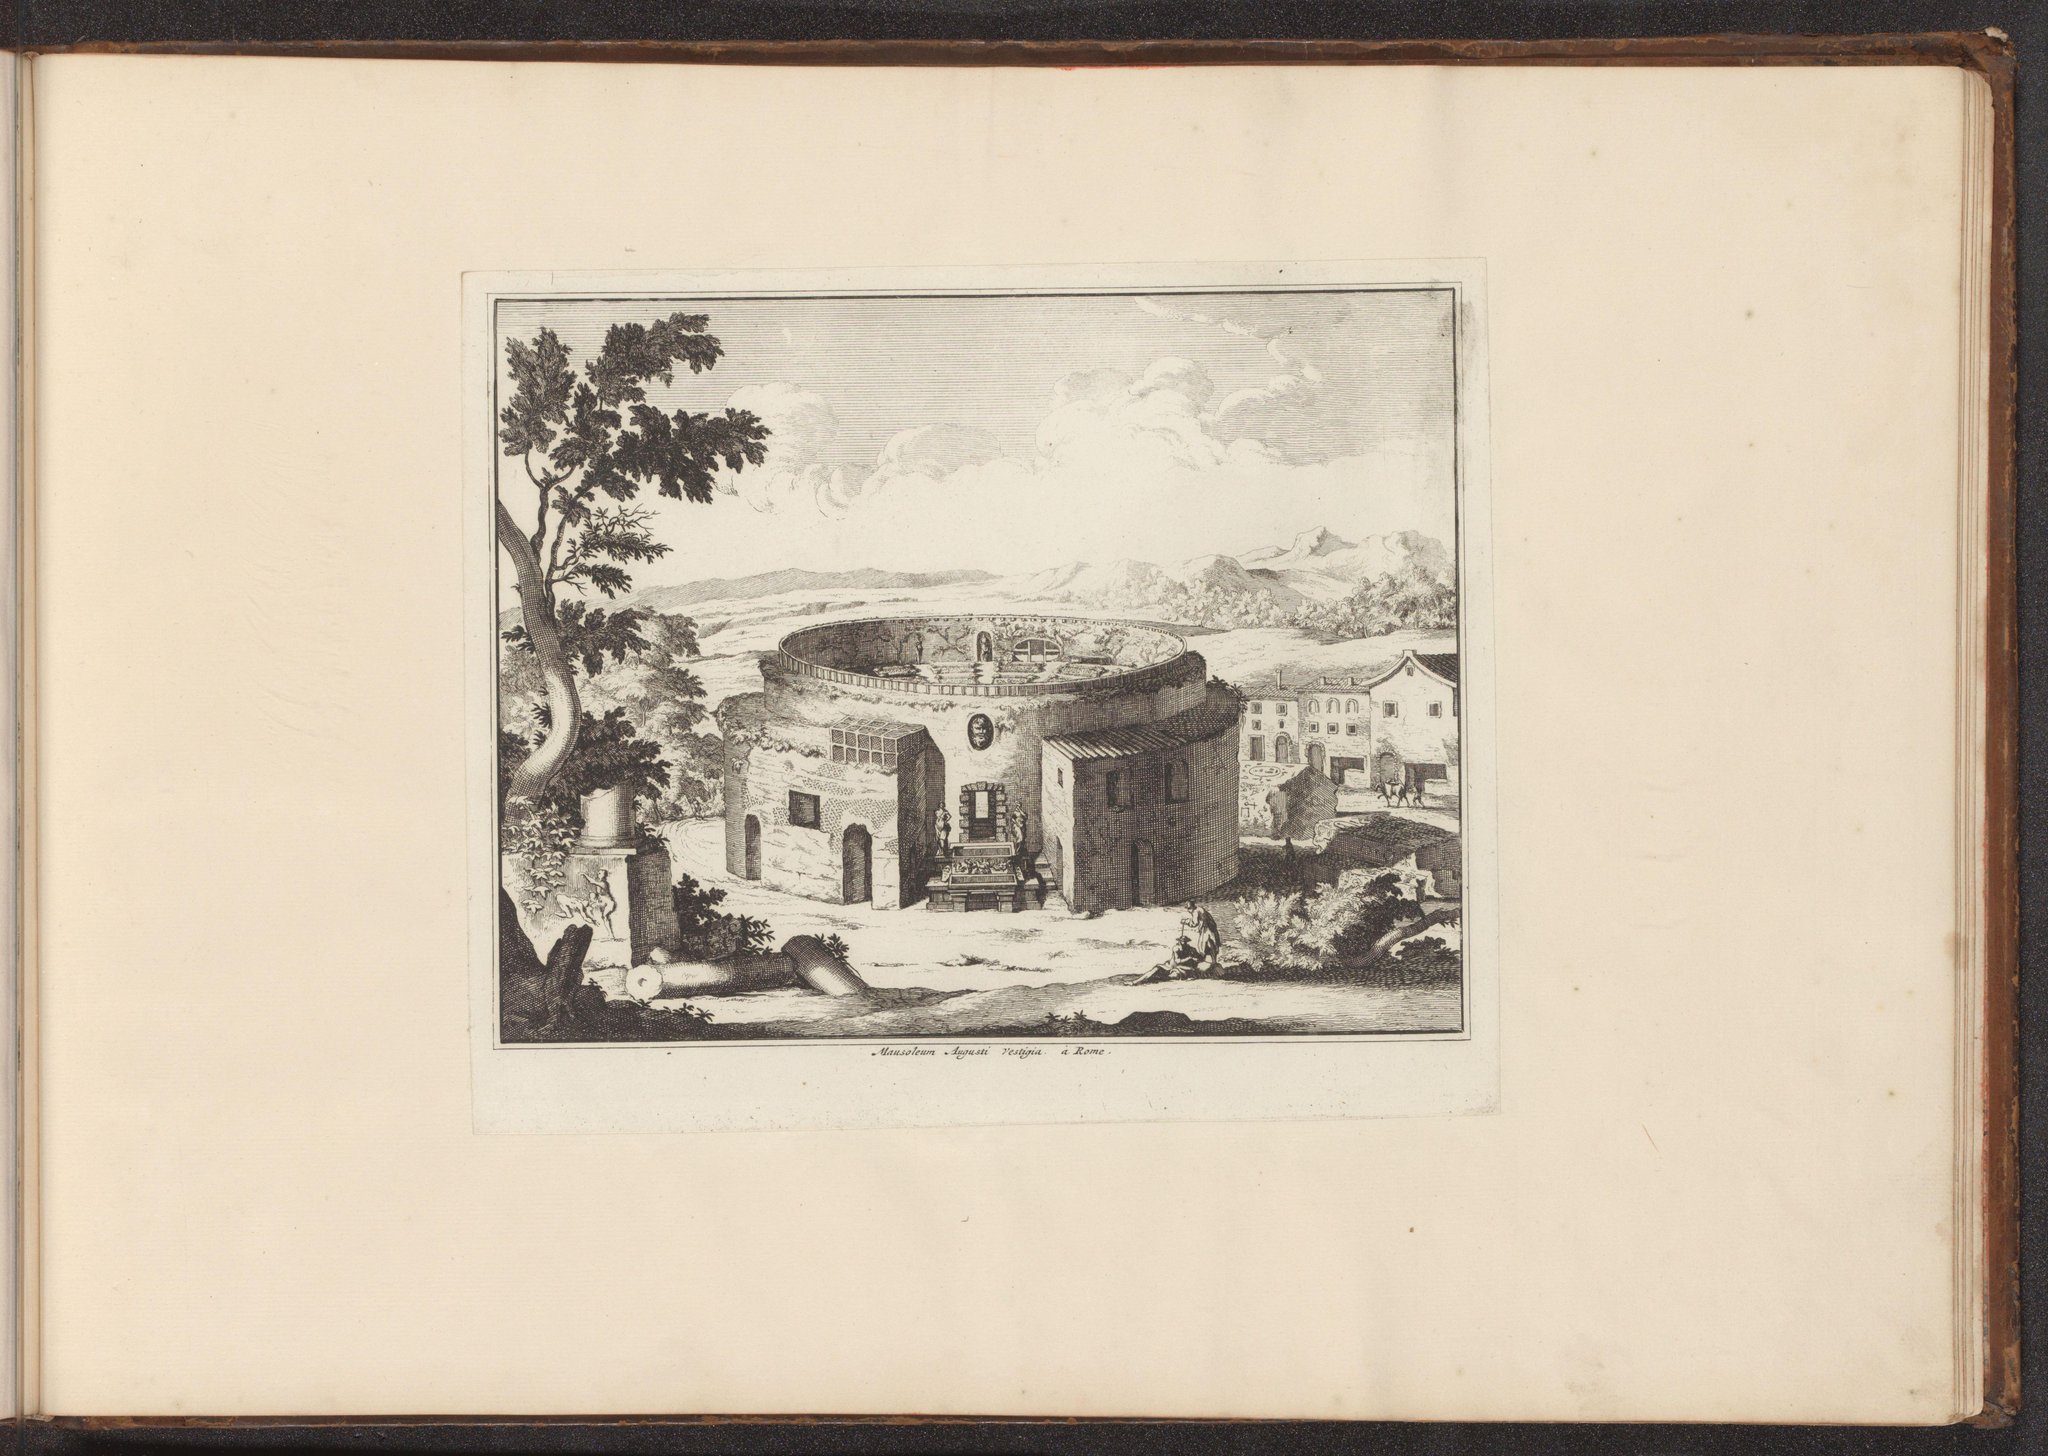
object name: print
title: Gezicht op de ruïne van het Mausoleum van Augustus te Rome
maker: Anonymous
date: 1700-1710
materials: paper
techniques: etching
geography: france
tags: ruin of a building ~ architecture, mausoleum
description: Gezicht op de ruïne van het Mausoleum van Augustus in een weids landschap te Rome. De prent maakt deel uit van een album.